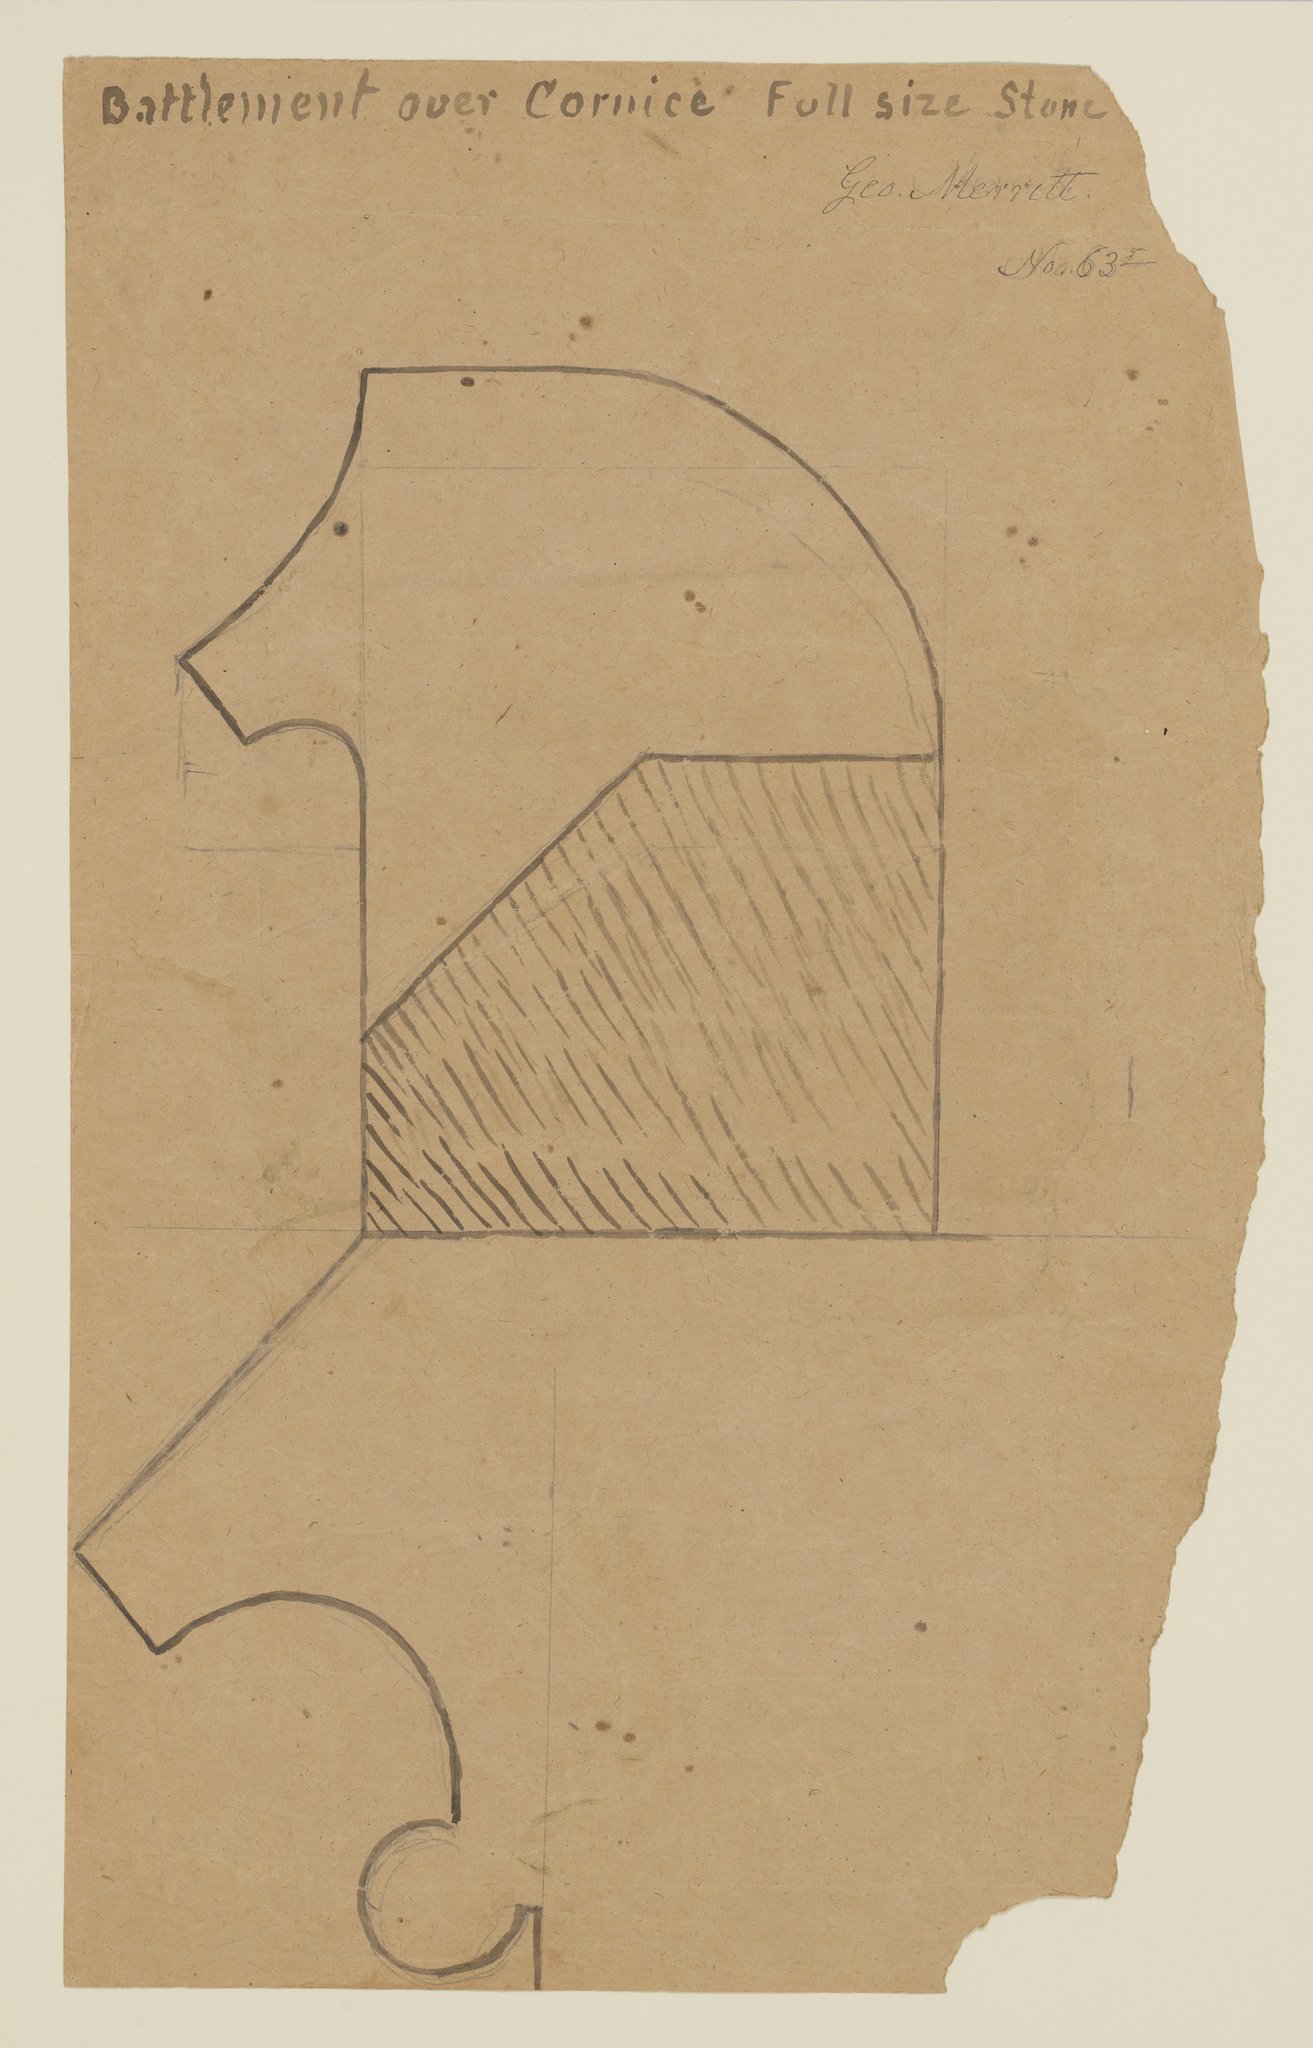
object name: drawing ornament architecture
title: Mason's Template for the Battlement over a Cornice at Lyndhurst for George Merritt, Tarrytown, New York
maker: alexander jackson davis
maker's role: artist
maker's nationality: american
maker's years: 1803-1892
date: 1864-1865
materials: graphite, watercolor